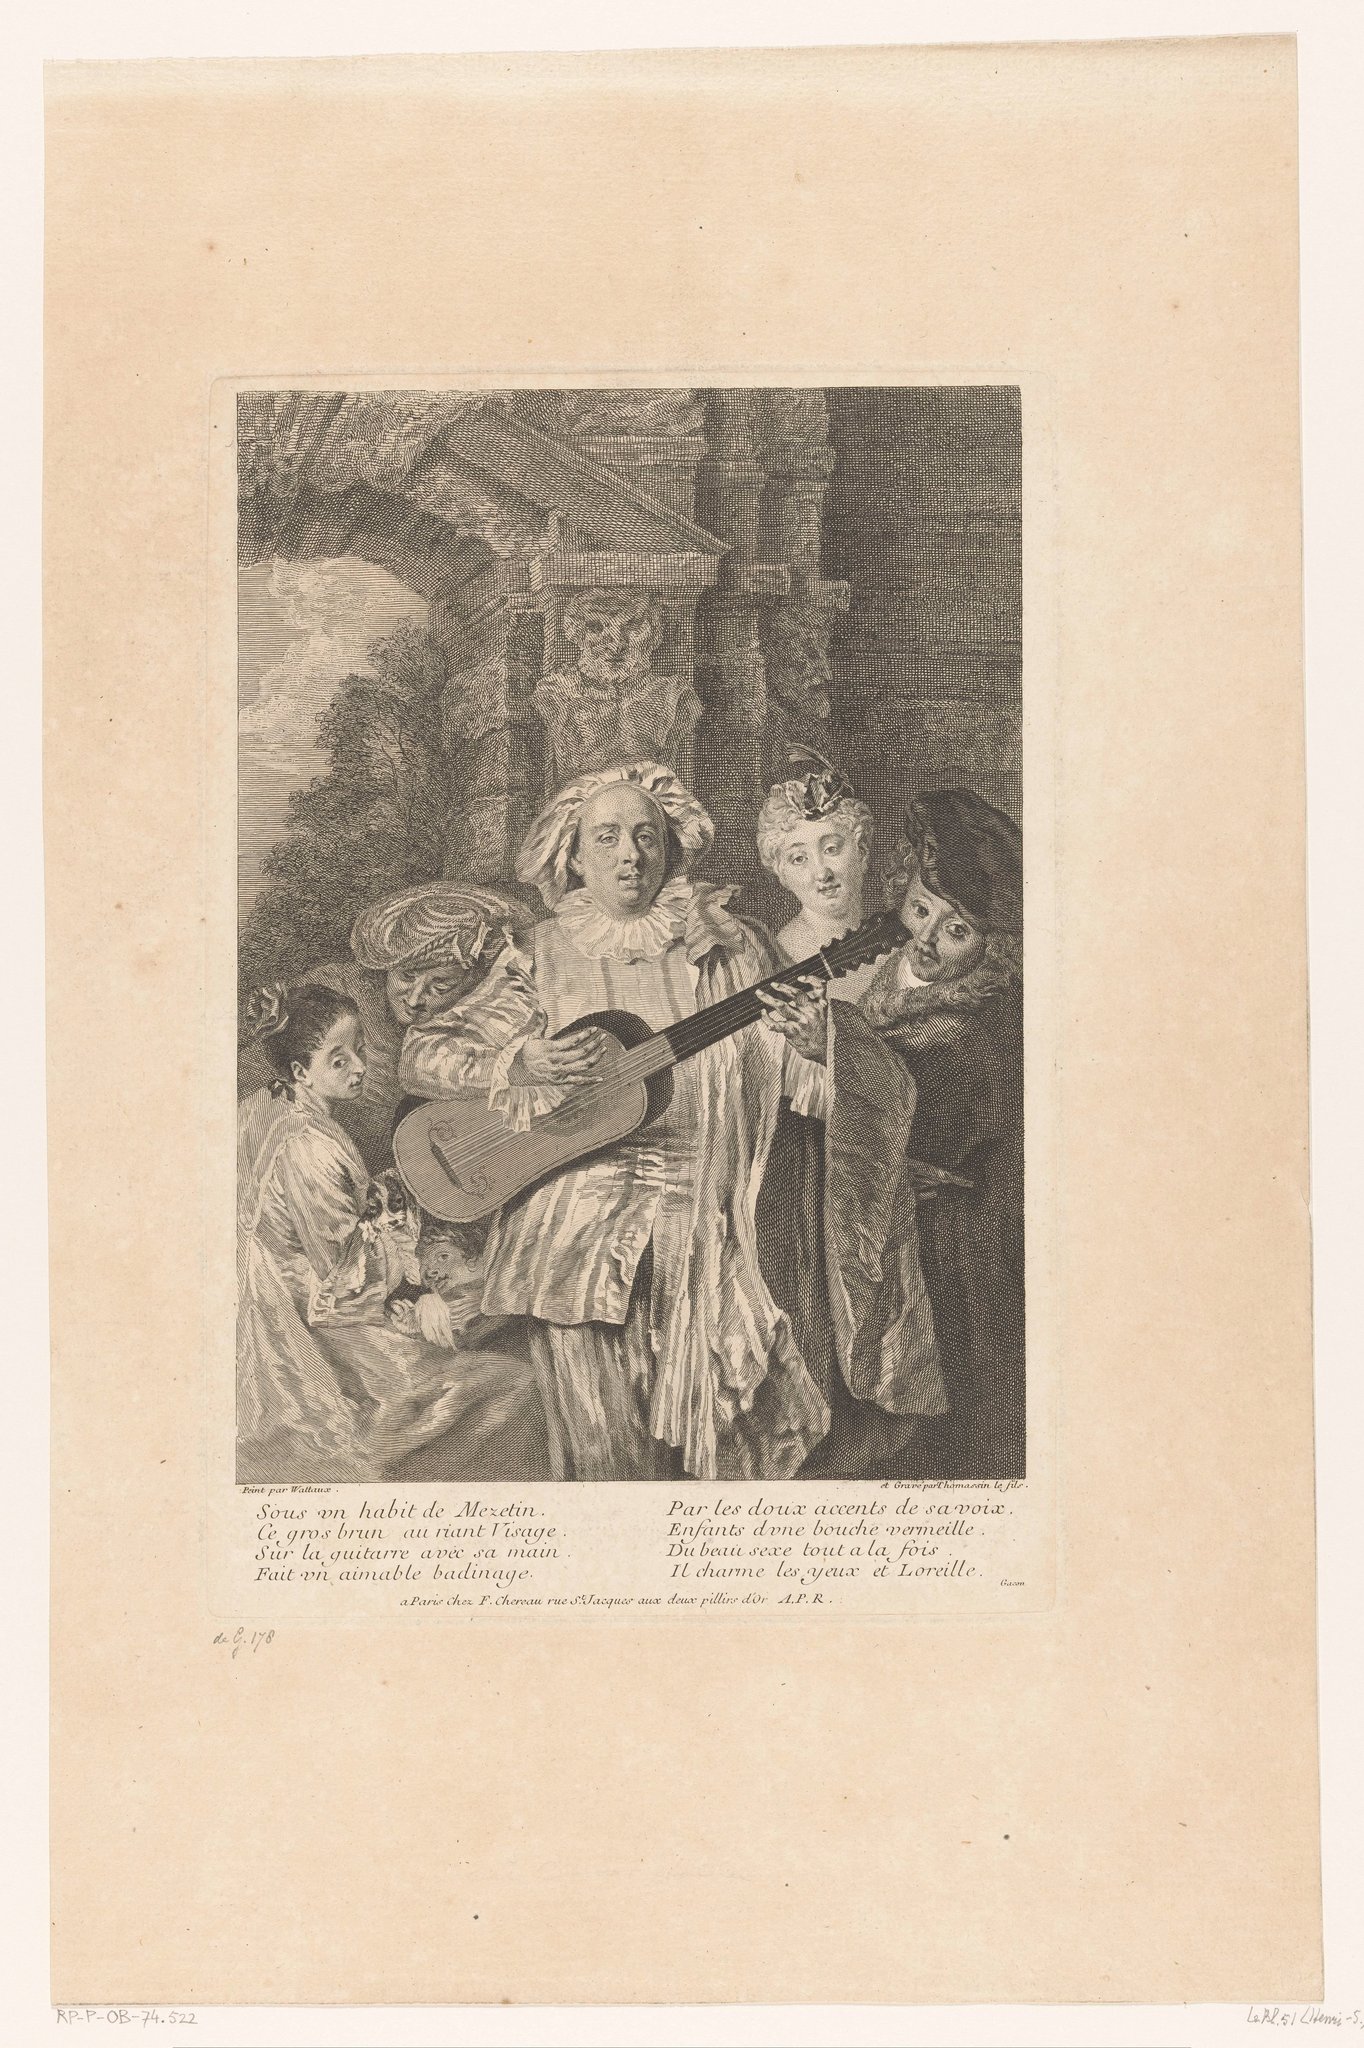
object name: print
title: Sous un habit de Mezetin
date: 1735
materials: paper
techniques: engraving, etching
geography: paris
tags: types in 'commedia dell'arte', cithern, mandolin, guitar, balalaika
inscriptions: collector's mark: Lugt 2228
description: Maakt deel uit van een serie van 271 platen naar schilderijen door Watteau, verdeeld over drie delen, gecoördineerd door Jean de Jullienne en uitgegeven in Parijs in 1735. Sommige platen werden reeds tijdens Watteau's leven gemaakt. De Julienne en Watteau waren goede vrienden. Het schilderij door Watteau bevindt zich in de Wallace Collection te Londen, inv.nr. P381.